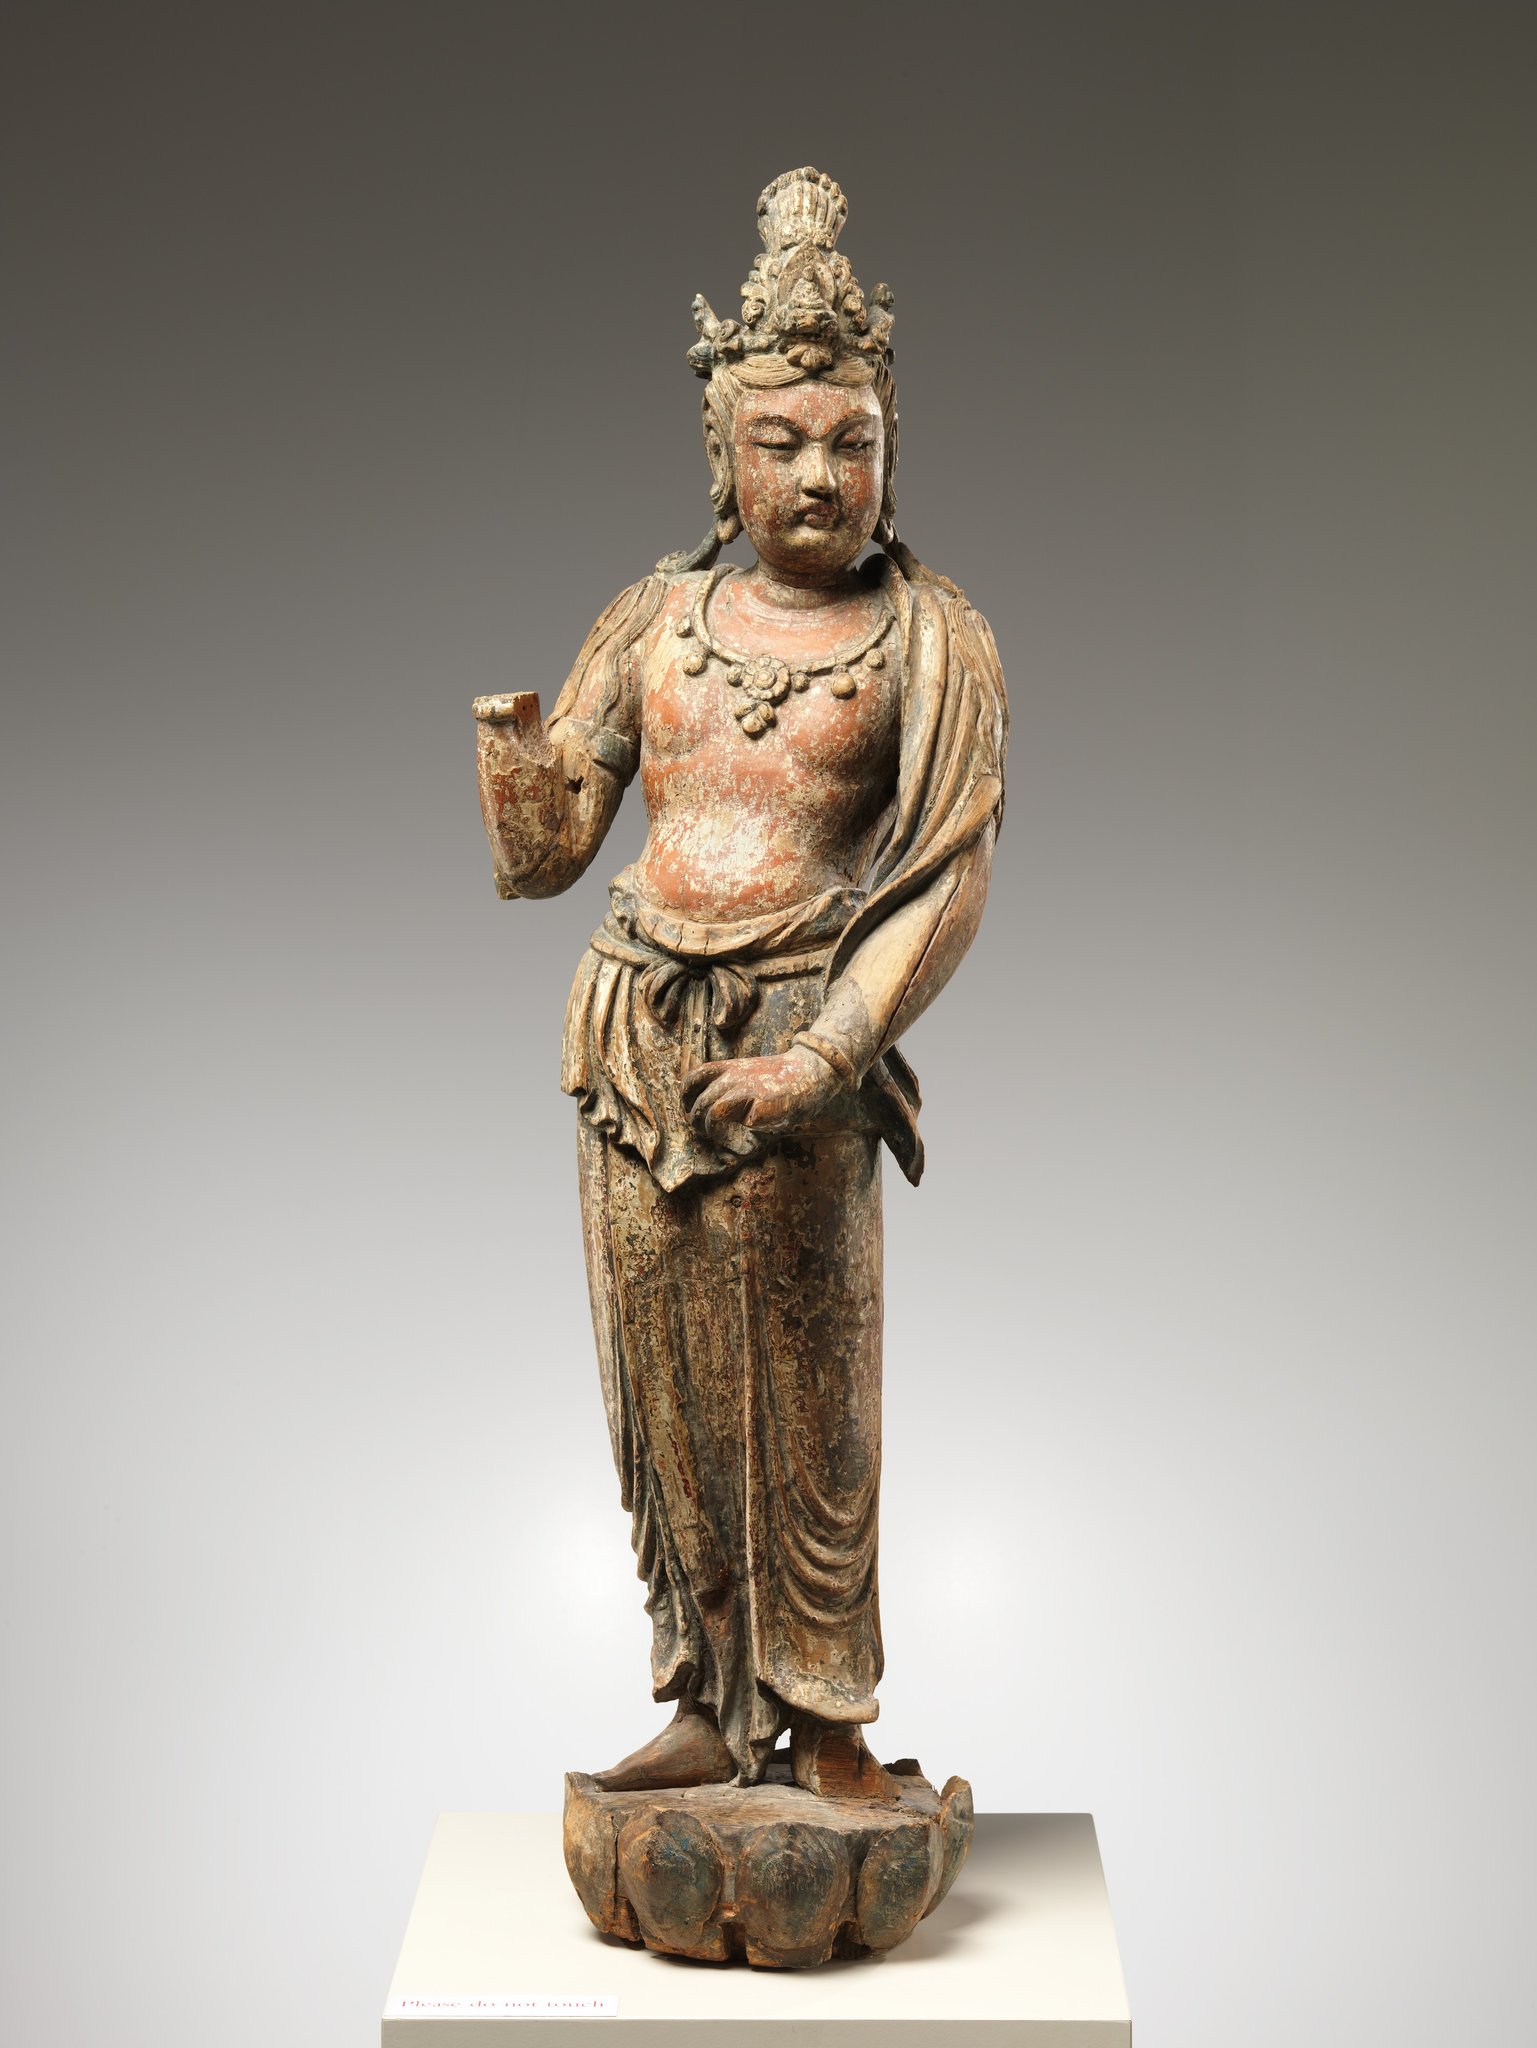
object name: figure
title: Bodhisattva Avalokiteshvara (Guanyin)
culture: chinese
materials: pigment, wood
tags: buddhism,avalokiteshvara,bodhisattvas